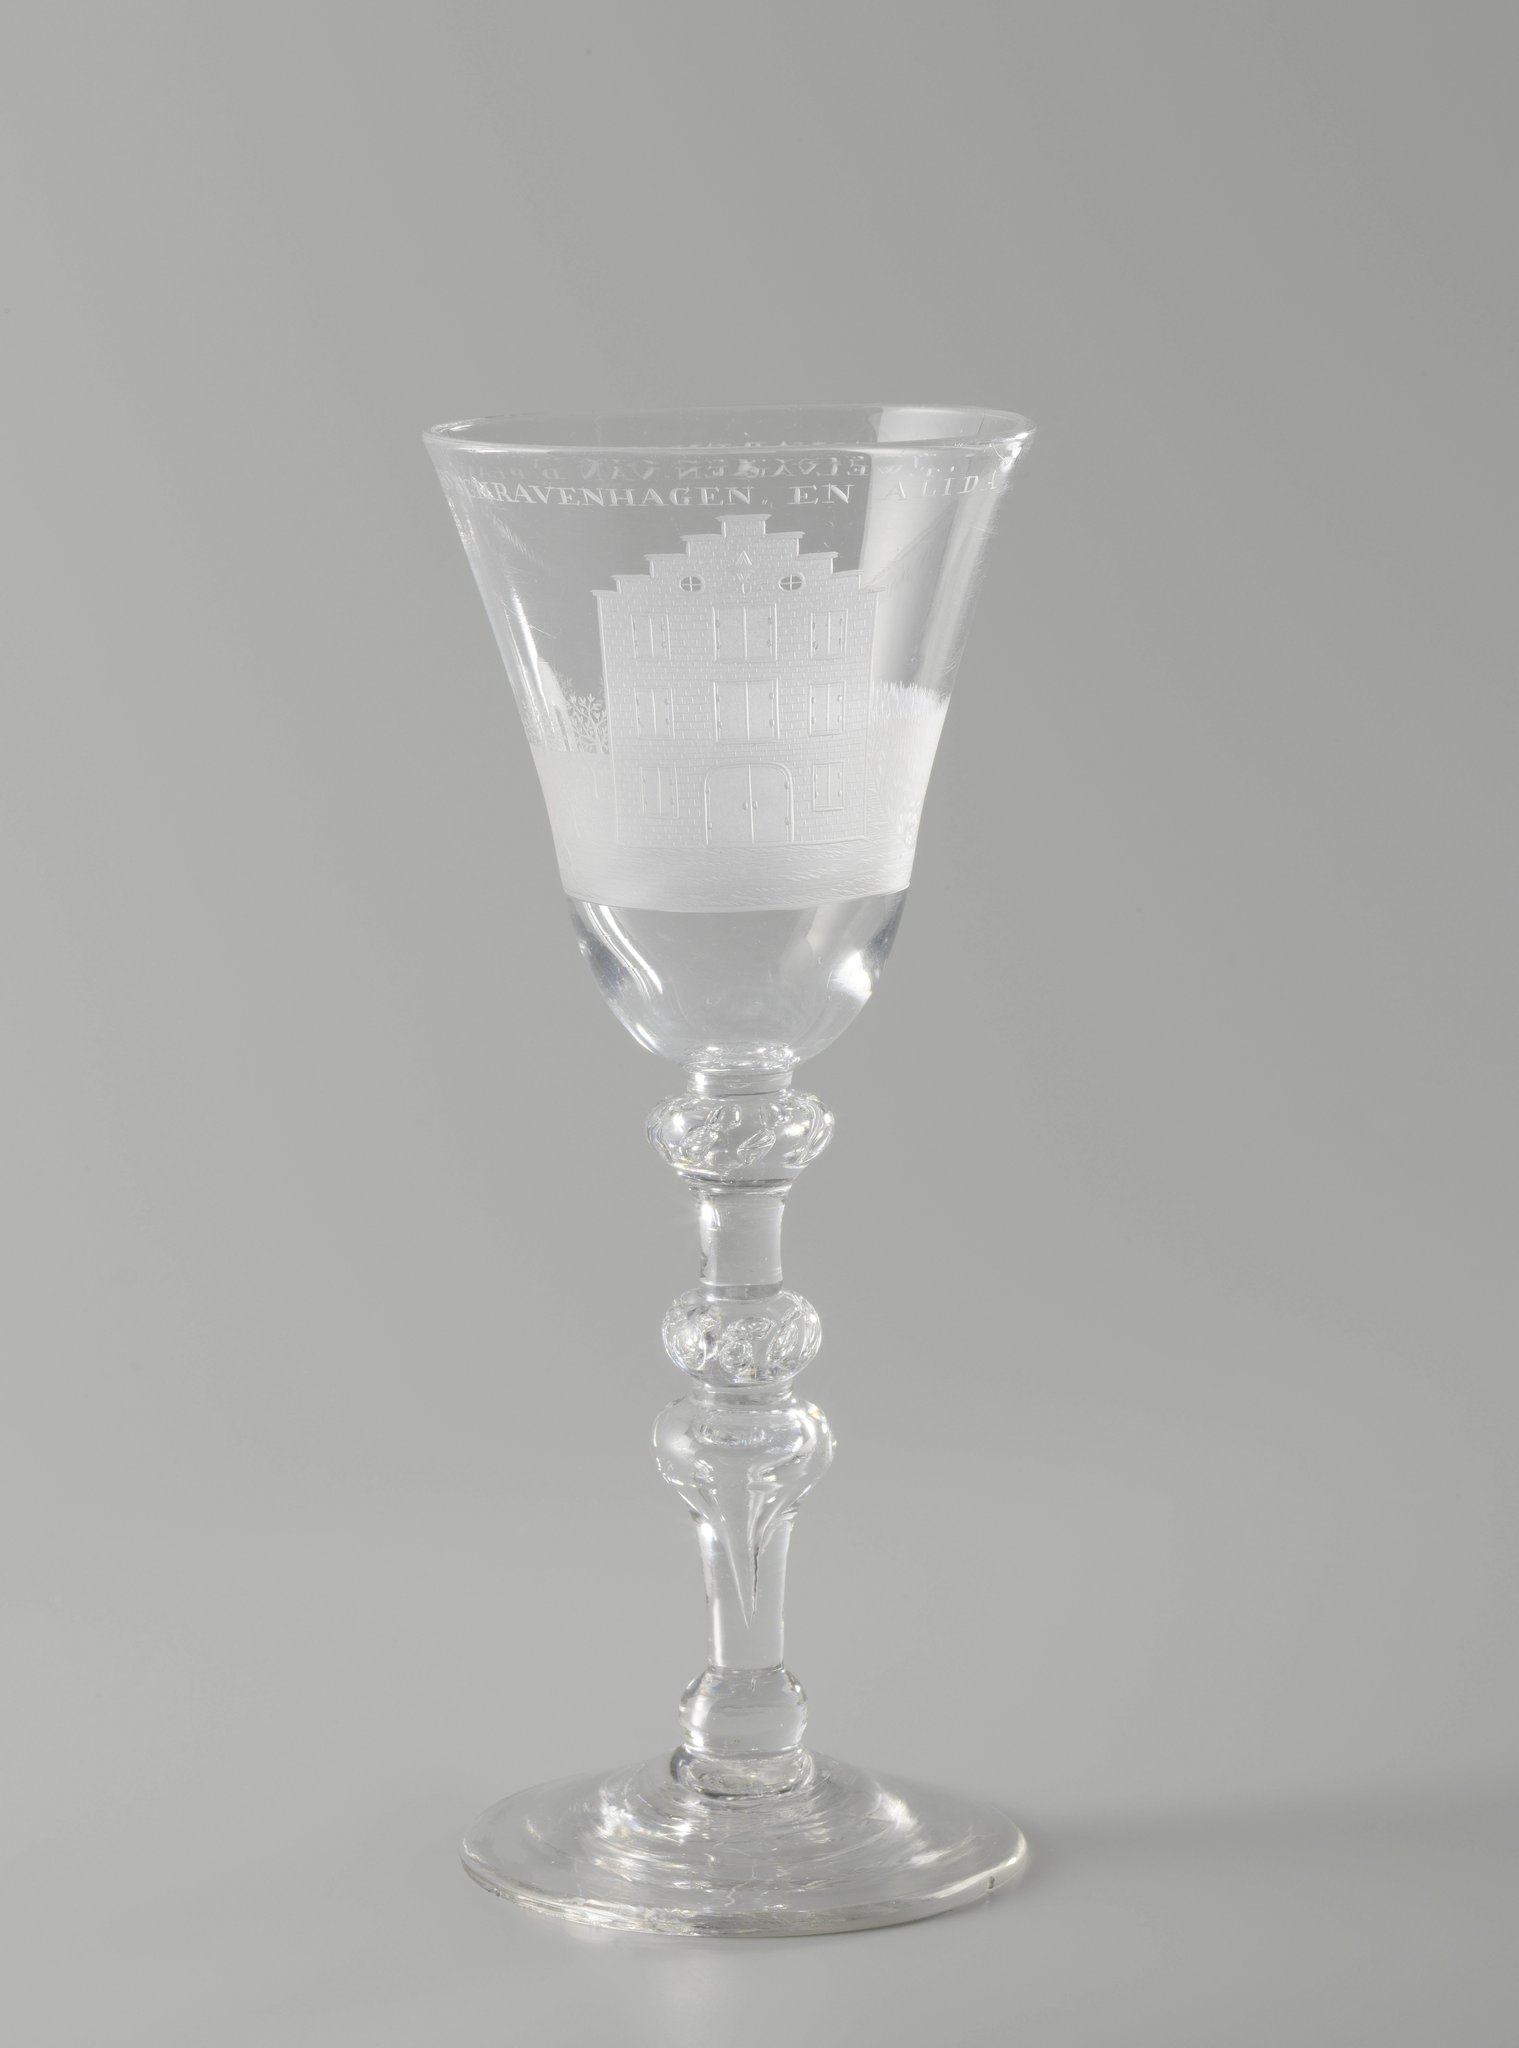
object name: goblet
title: Wine Glass with Views of the Schravenhagen and Alida Plantations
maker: simon jacob sang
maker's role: glasgraveur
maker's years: 1720-1786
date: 1752-1775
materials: glass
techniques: glassblowing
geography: amsterdam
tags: plantation, suriname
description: When this glass was engraved, the Surinam plantations of Schravenhagen and Alida were owned by Maria Lemmers-Wossink. She lived in a grand house in Paramaribo, a sign that the plantations were very profitable. The engraving shows a warehouse and sugar cane being harvested by people in slavery.